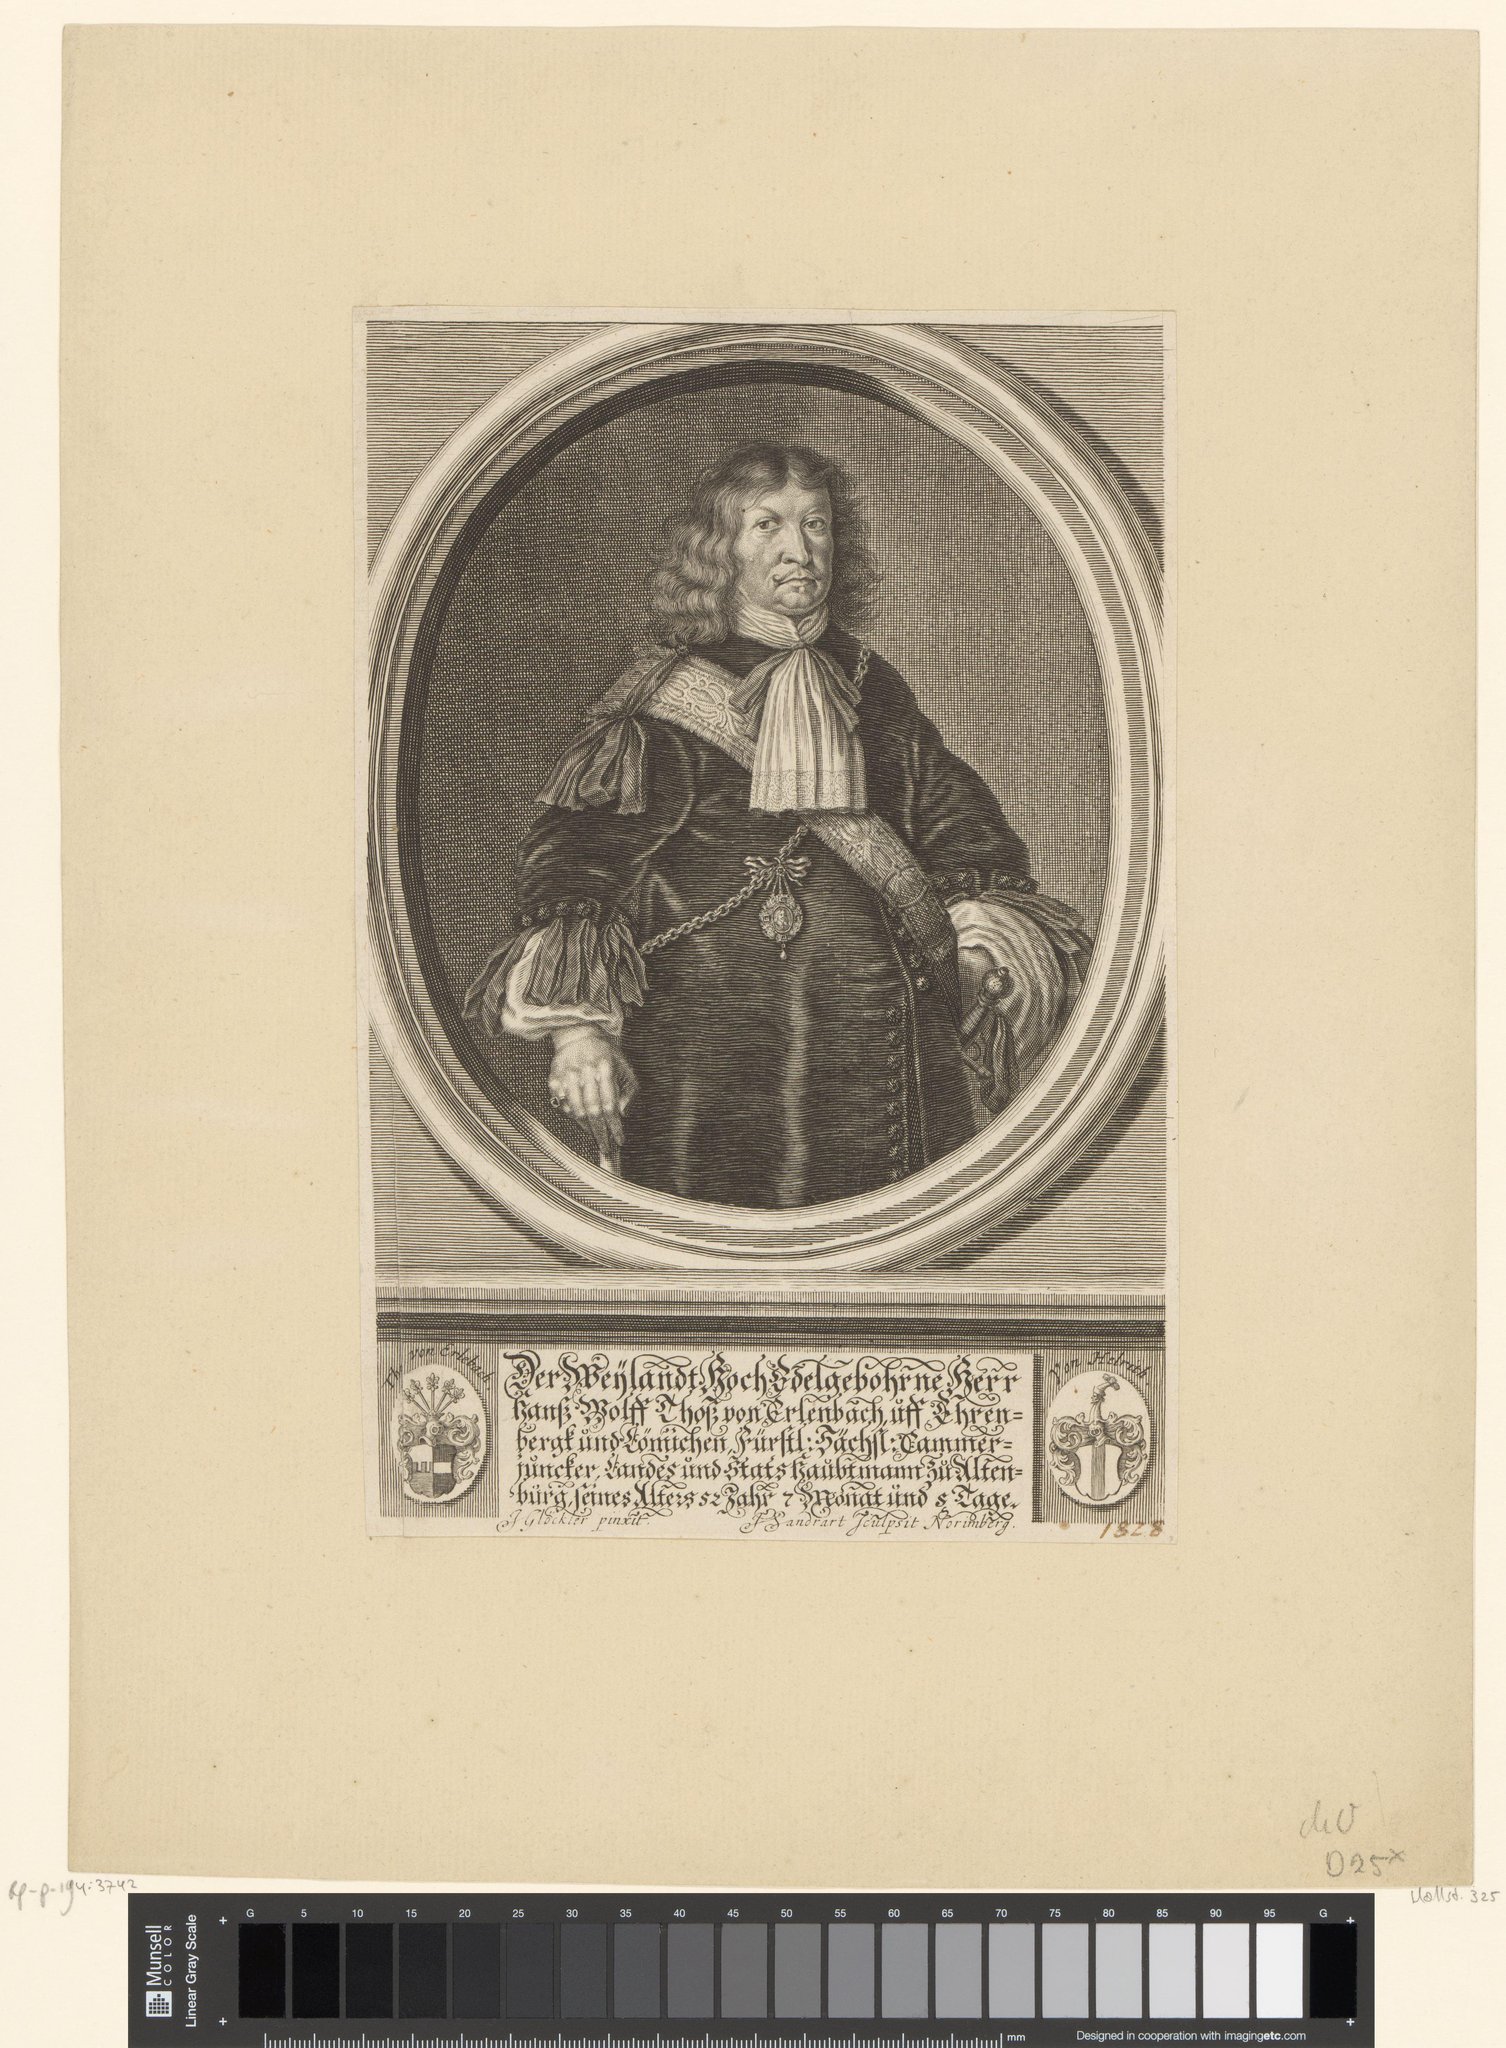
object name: print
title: Portret van Hans Wolf Thoss von Erlenbach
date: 1668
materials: paper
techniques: engraving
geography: nuremberg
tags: historical persons, pendant, trinket, 'breloque', armorial bearing, heraldry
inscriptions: collector's mark: Lugt 2228